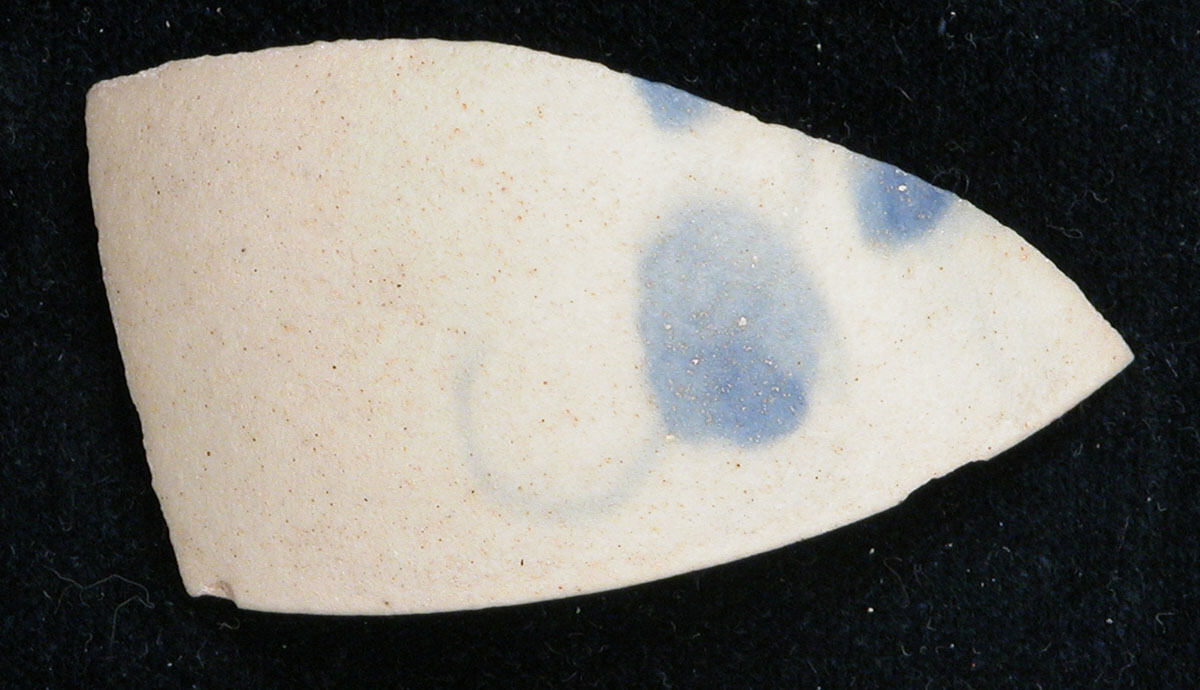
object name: fragment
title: Ceramic Fragment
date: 1201-1600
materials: stonepaste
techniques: glazing, painting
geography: saudi arabia